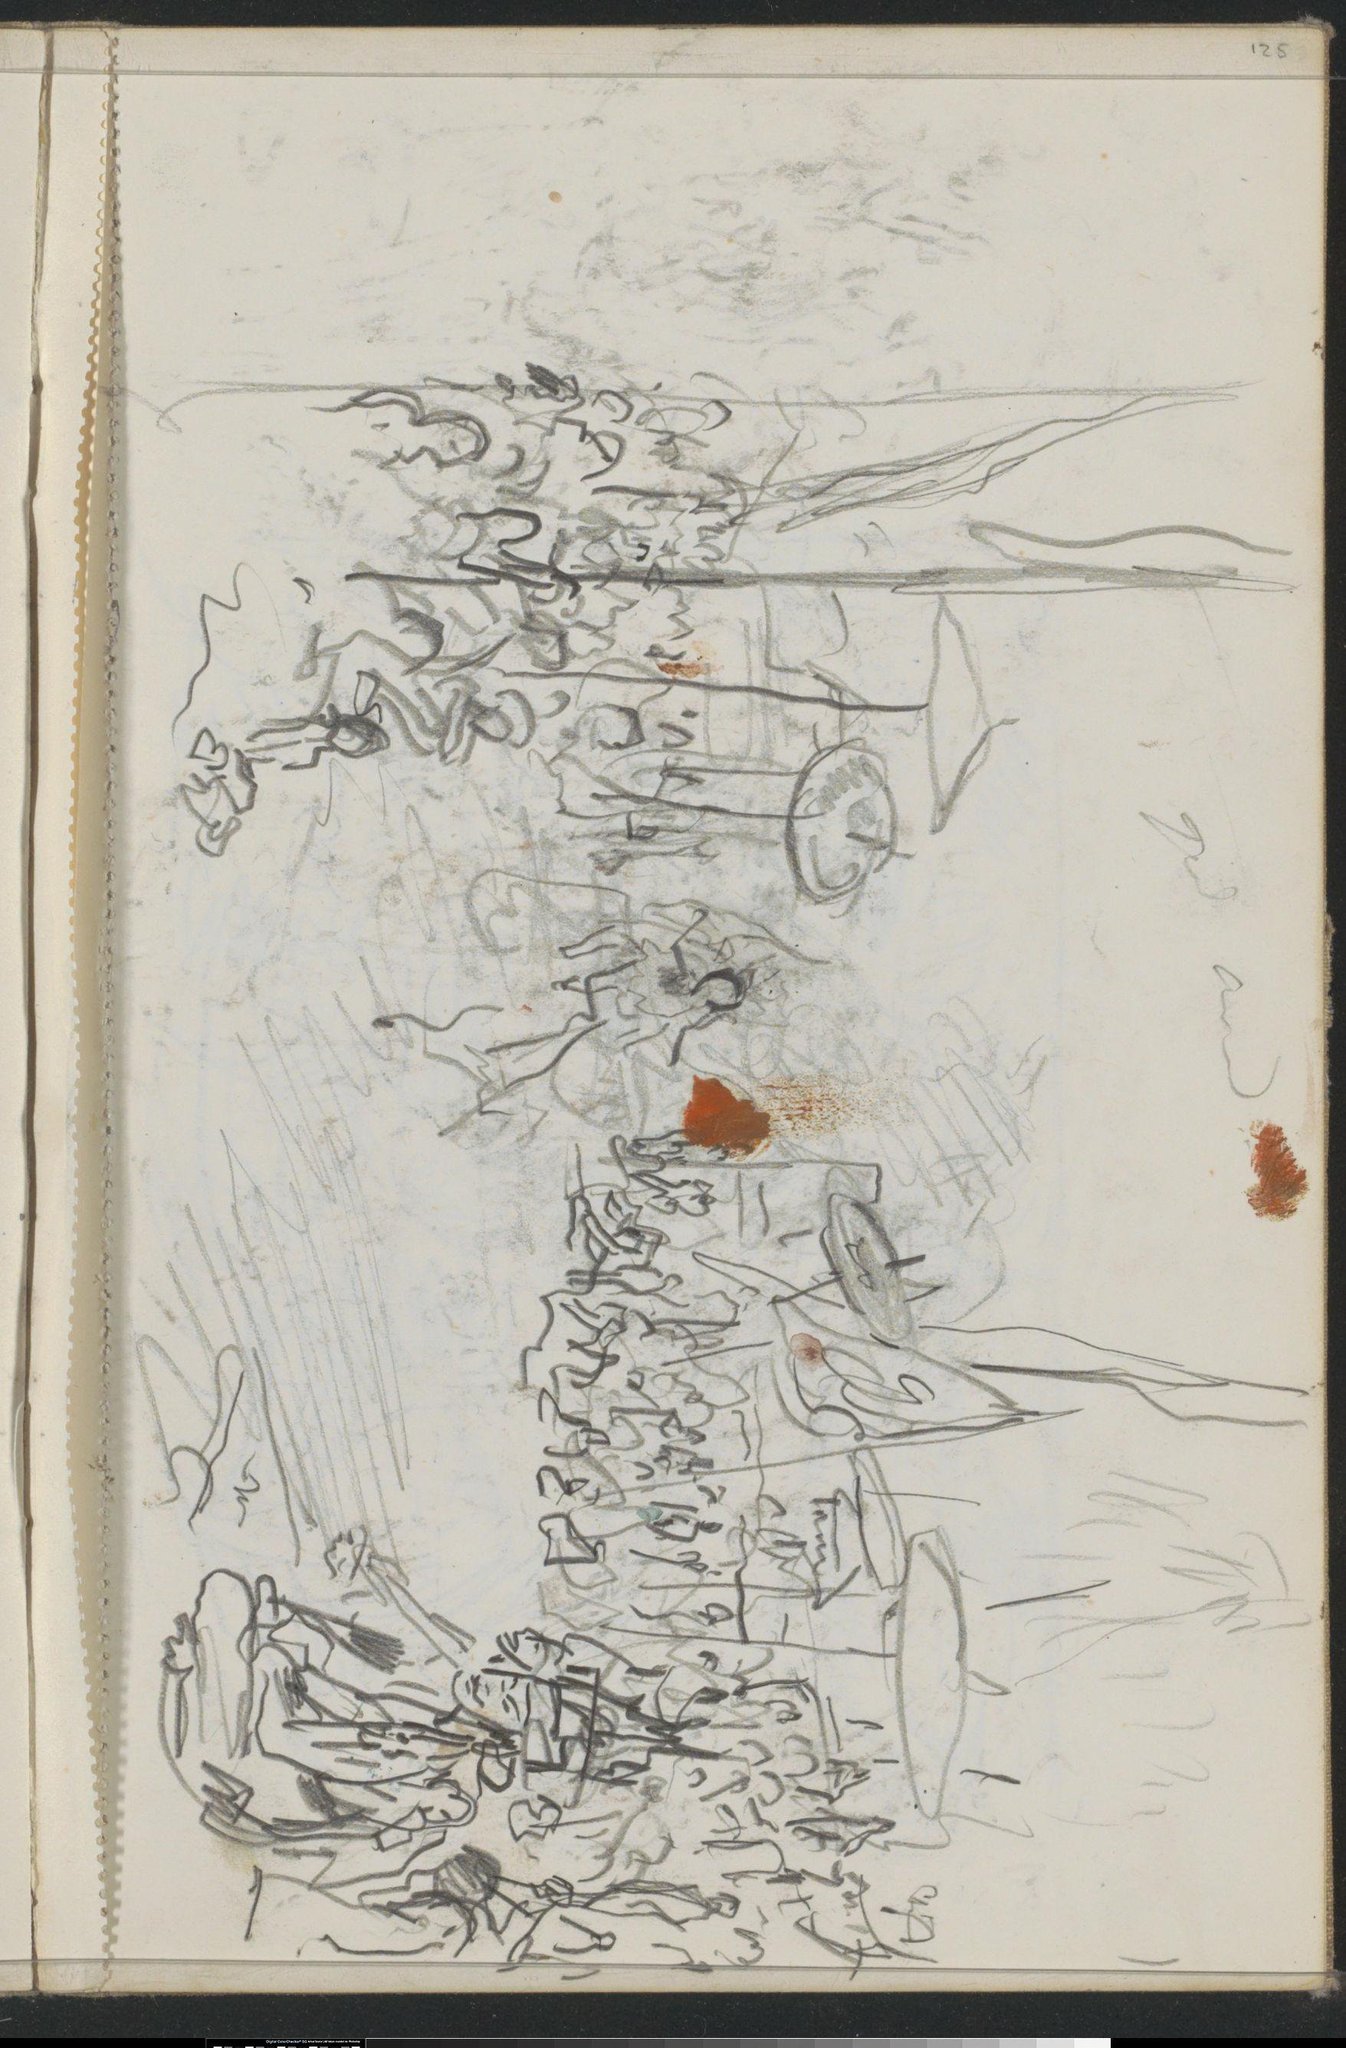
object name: sketchbook leaf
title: Traditionele Indonesische dansvoorstelling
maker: marius bauer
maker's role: draughtsman, print maker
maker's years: 1867-1932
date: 1925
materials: paper, pencil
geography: indonesia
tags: asiatic races and peoples, the audience ~ art performance, folk costume, regional costume, one person dancing alone, parasol, sunshade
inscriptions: kleurnotitie, handgeschreven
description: Enkele toeschouwers zitten onder parasols. Pagina 125 uit een schetsboek met 74 bladen.